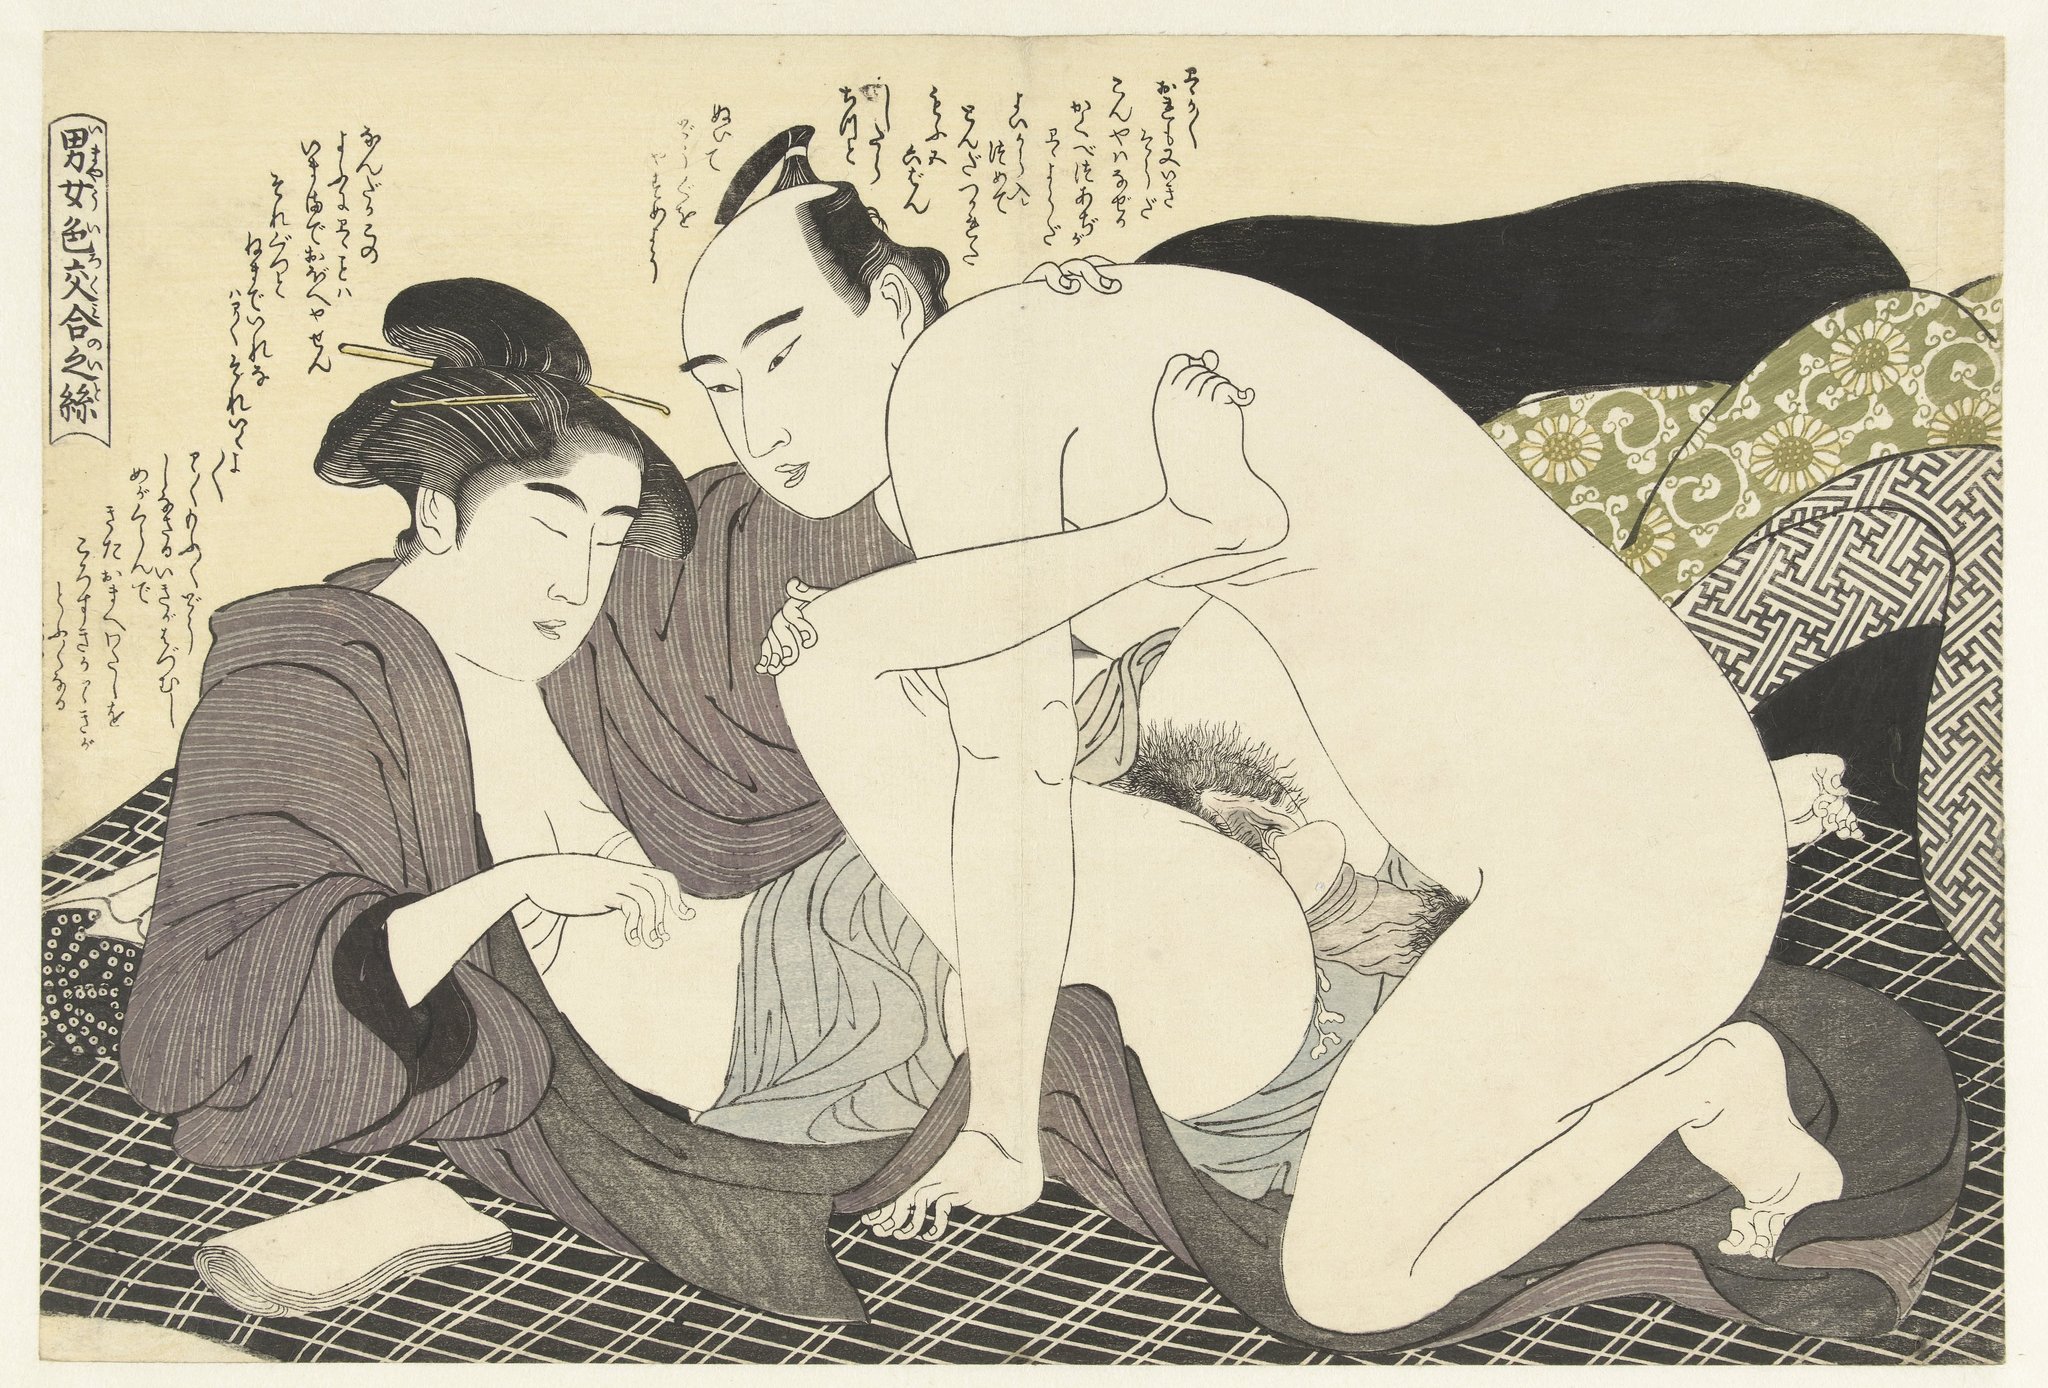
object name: print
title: Jonge man en vrouw bedrijven de liefde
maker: katsukawa shunchō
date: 1789-1790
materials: paper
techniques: woodcut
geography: japan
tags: coitus, cohabiting, sexual intercourse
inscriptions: collector's mark: Lugt 2760, collector's mark: Lugt 2228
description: Naakte man en half ontkleede vrouw met gesloten ogen, bedrijven de liefde op een zwart-wit geruit kleed.